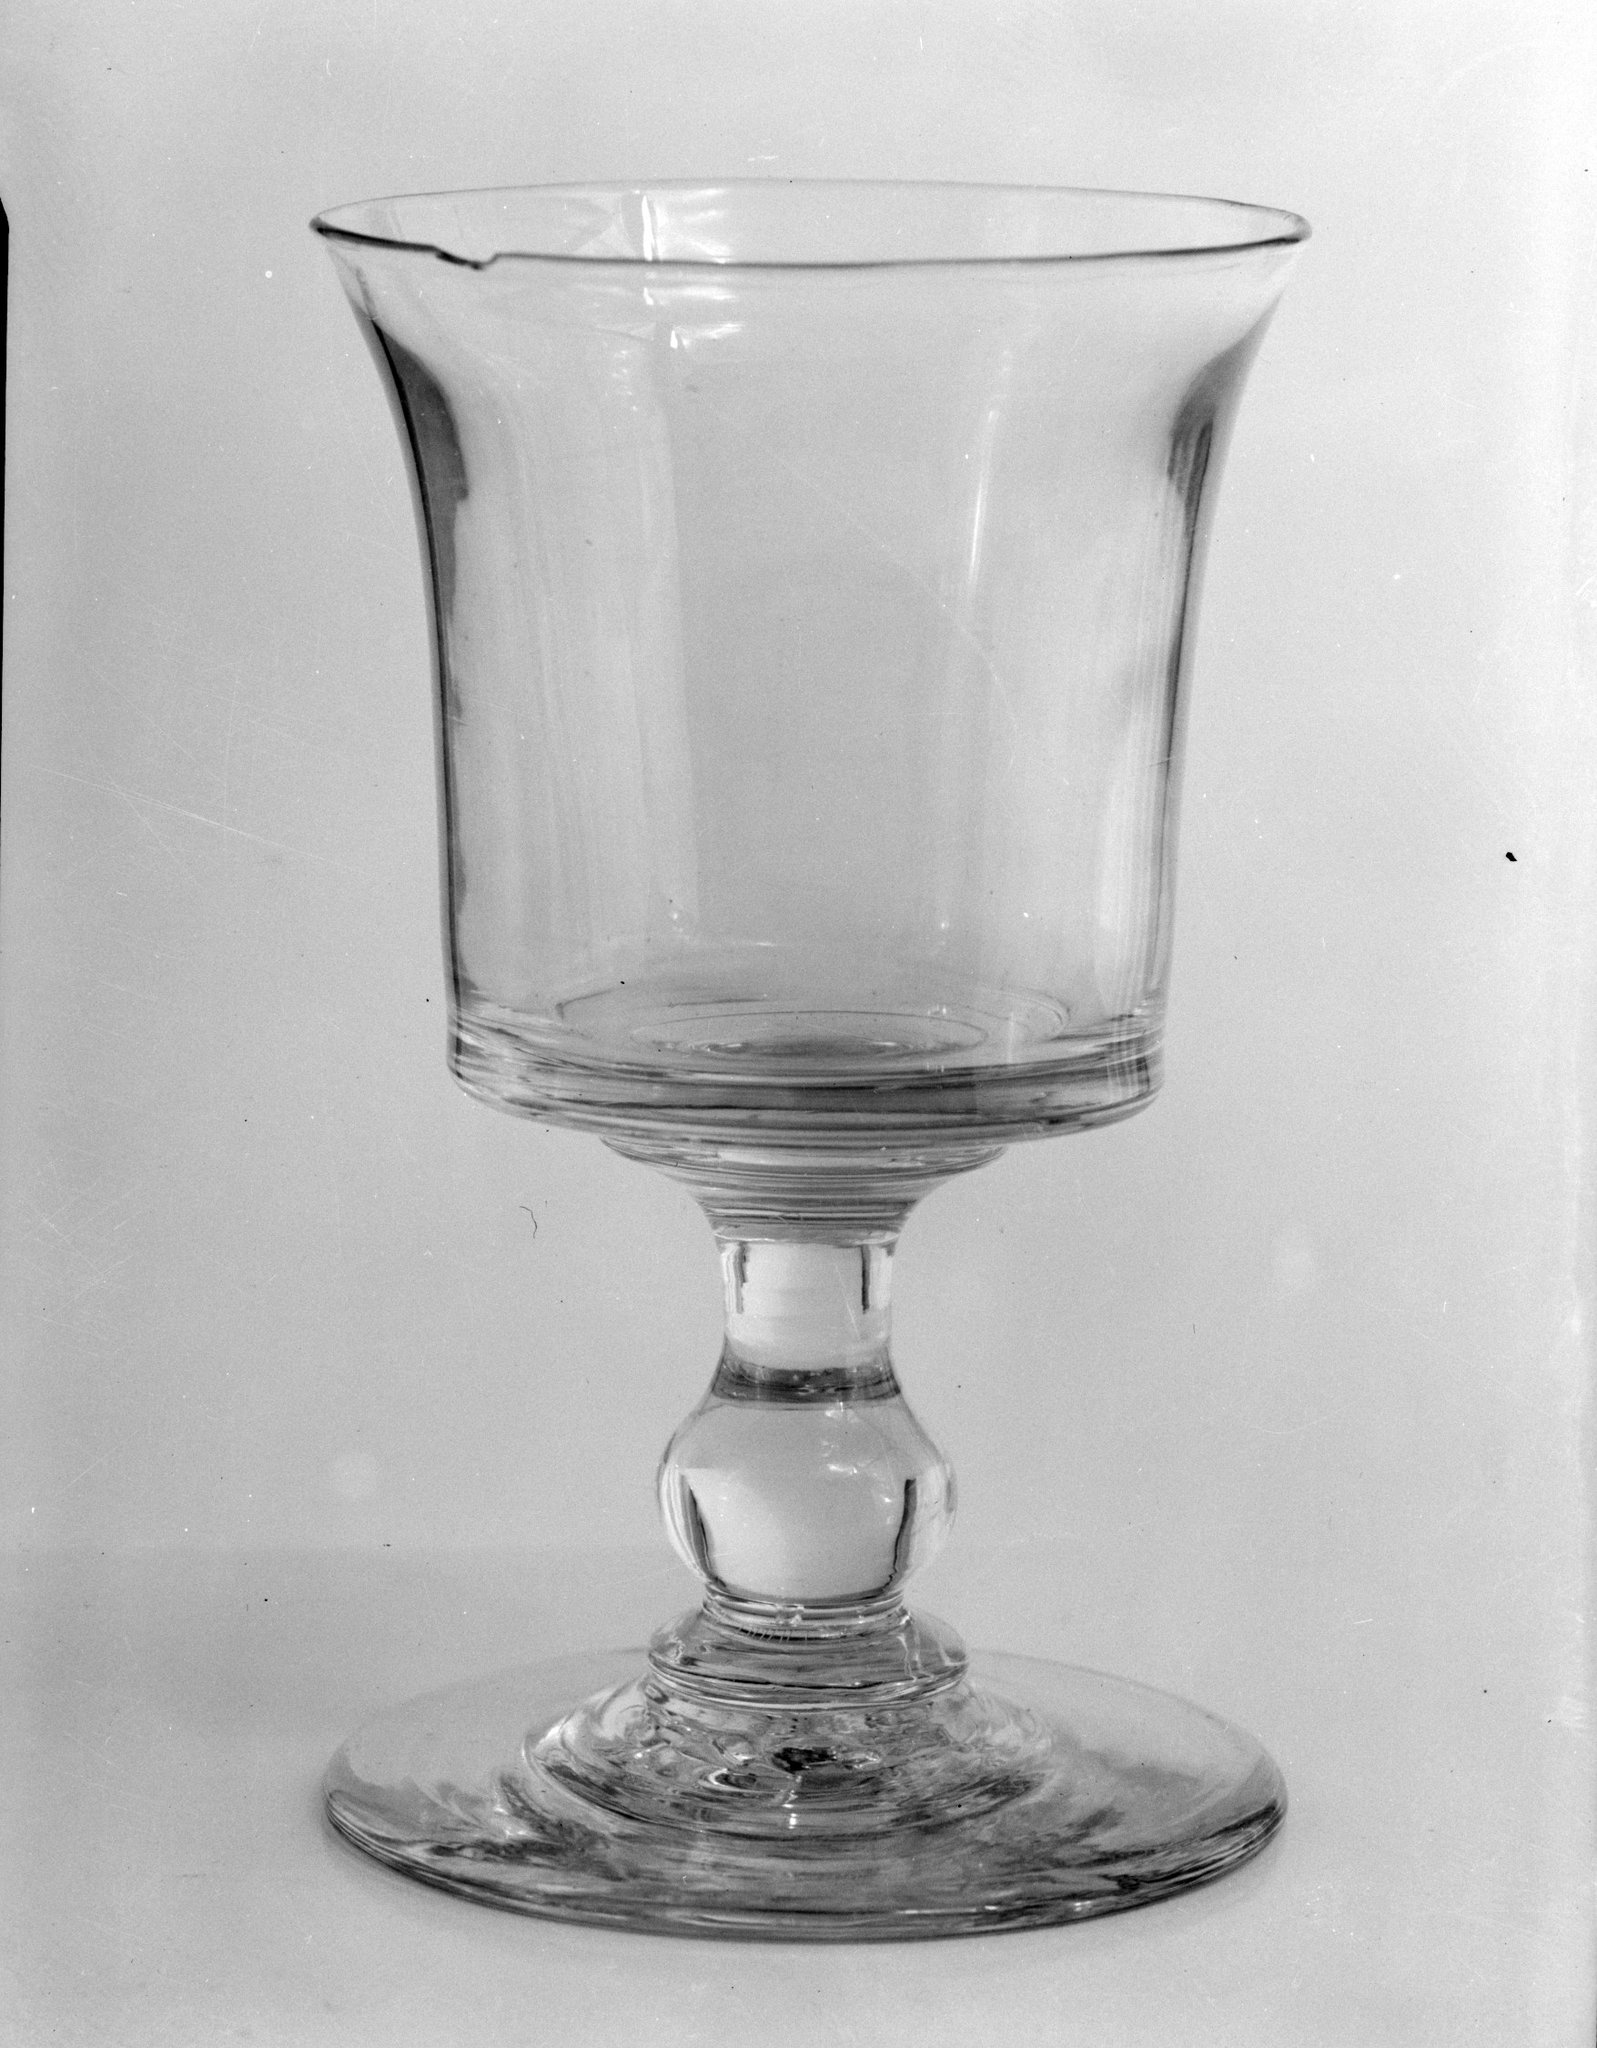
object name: goblet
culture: american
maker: jersey glass company of george dummer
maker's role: maker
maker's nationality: american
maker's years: 1824-1862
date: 1825-1850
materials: glass, lead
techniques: glassblowing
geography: united states